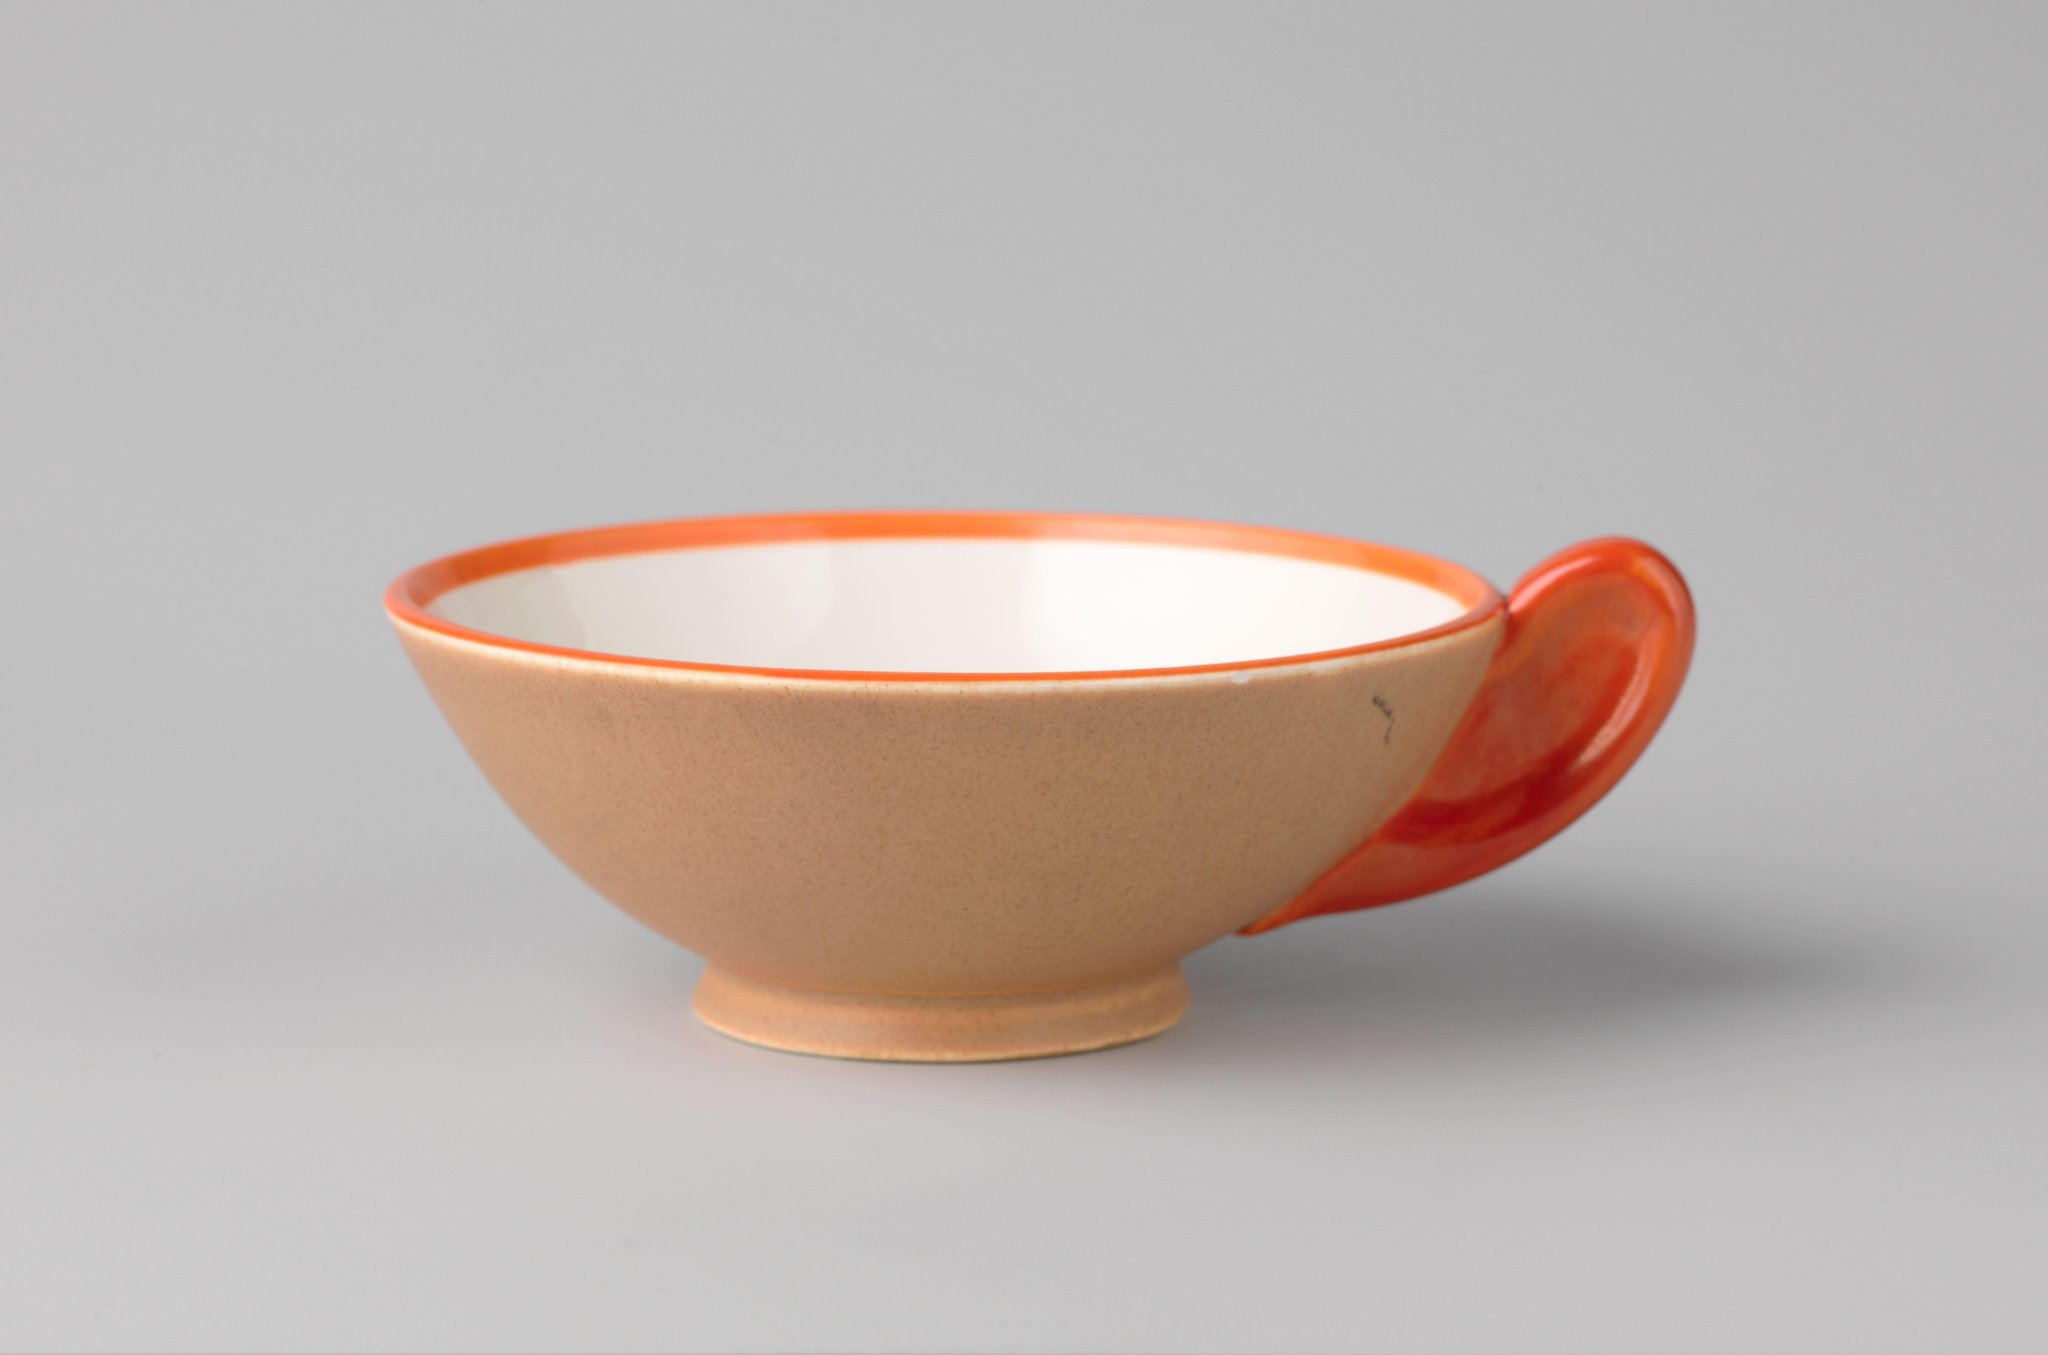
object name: tea cup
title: Theekop, deel van een theeservies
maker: edmond bellefroid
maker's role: ceramicist, painter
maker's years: 1893-1971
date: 1934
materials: earthenware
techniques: painted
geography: maastricht